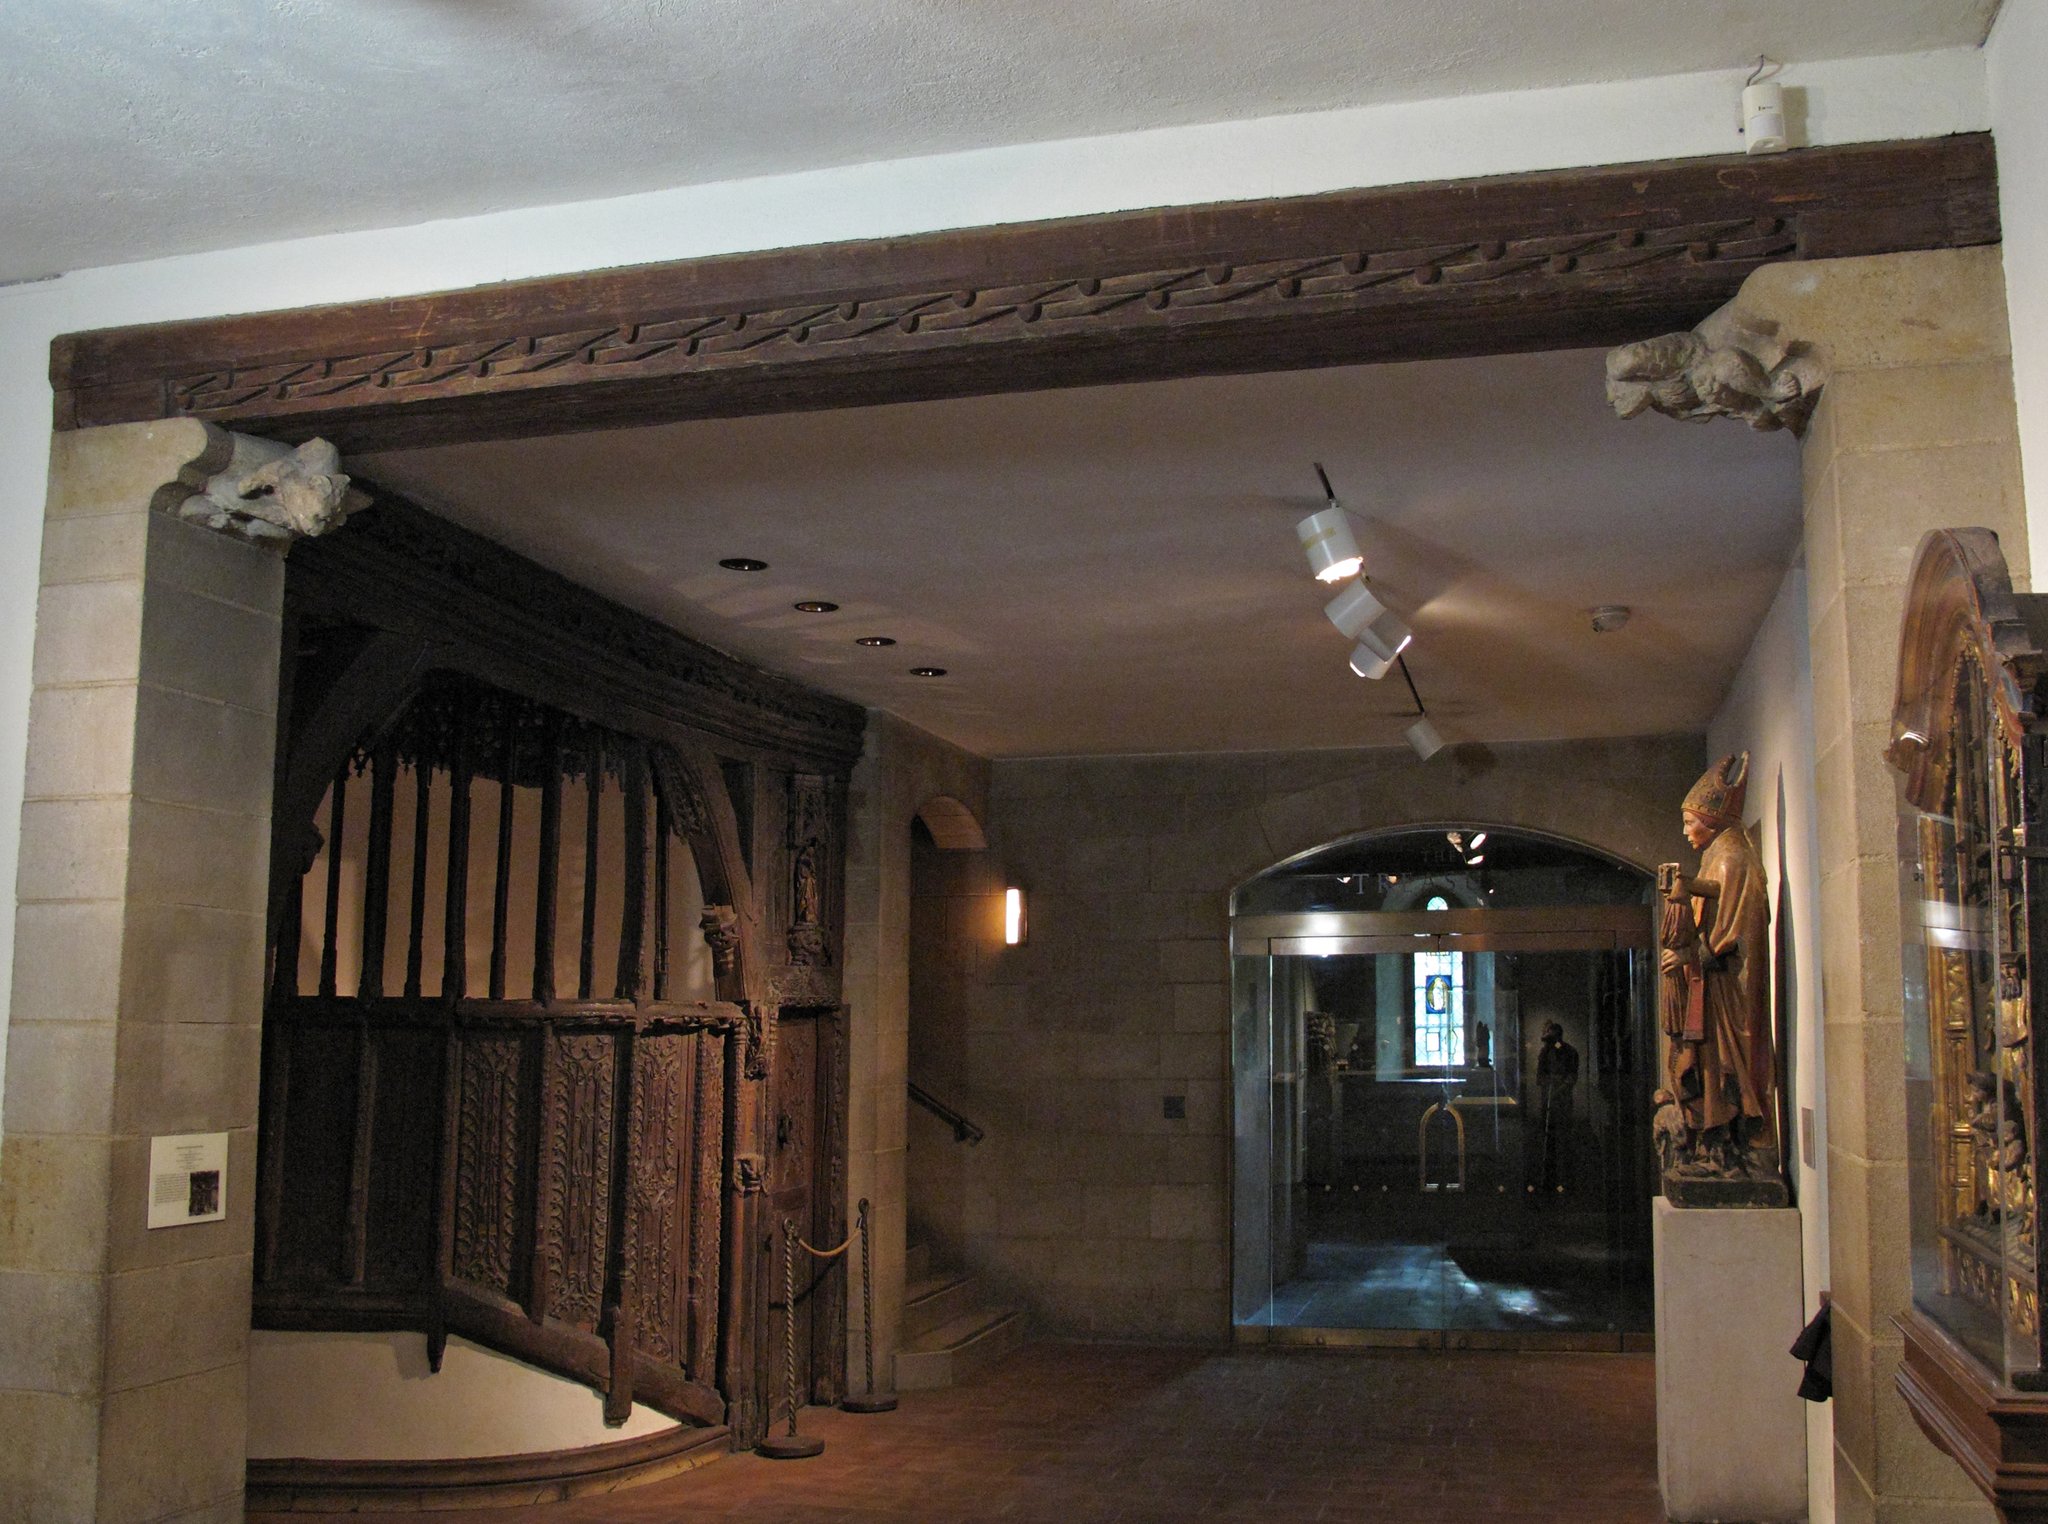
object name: beam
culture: european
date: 1401-1700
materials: wood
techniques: carving